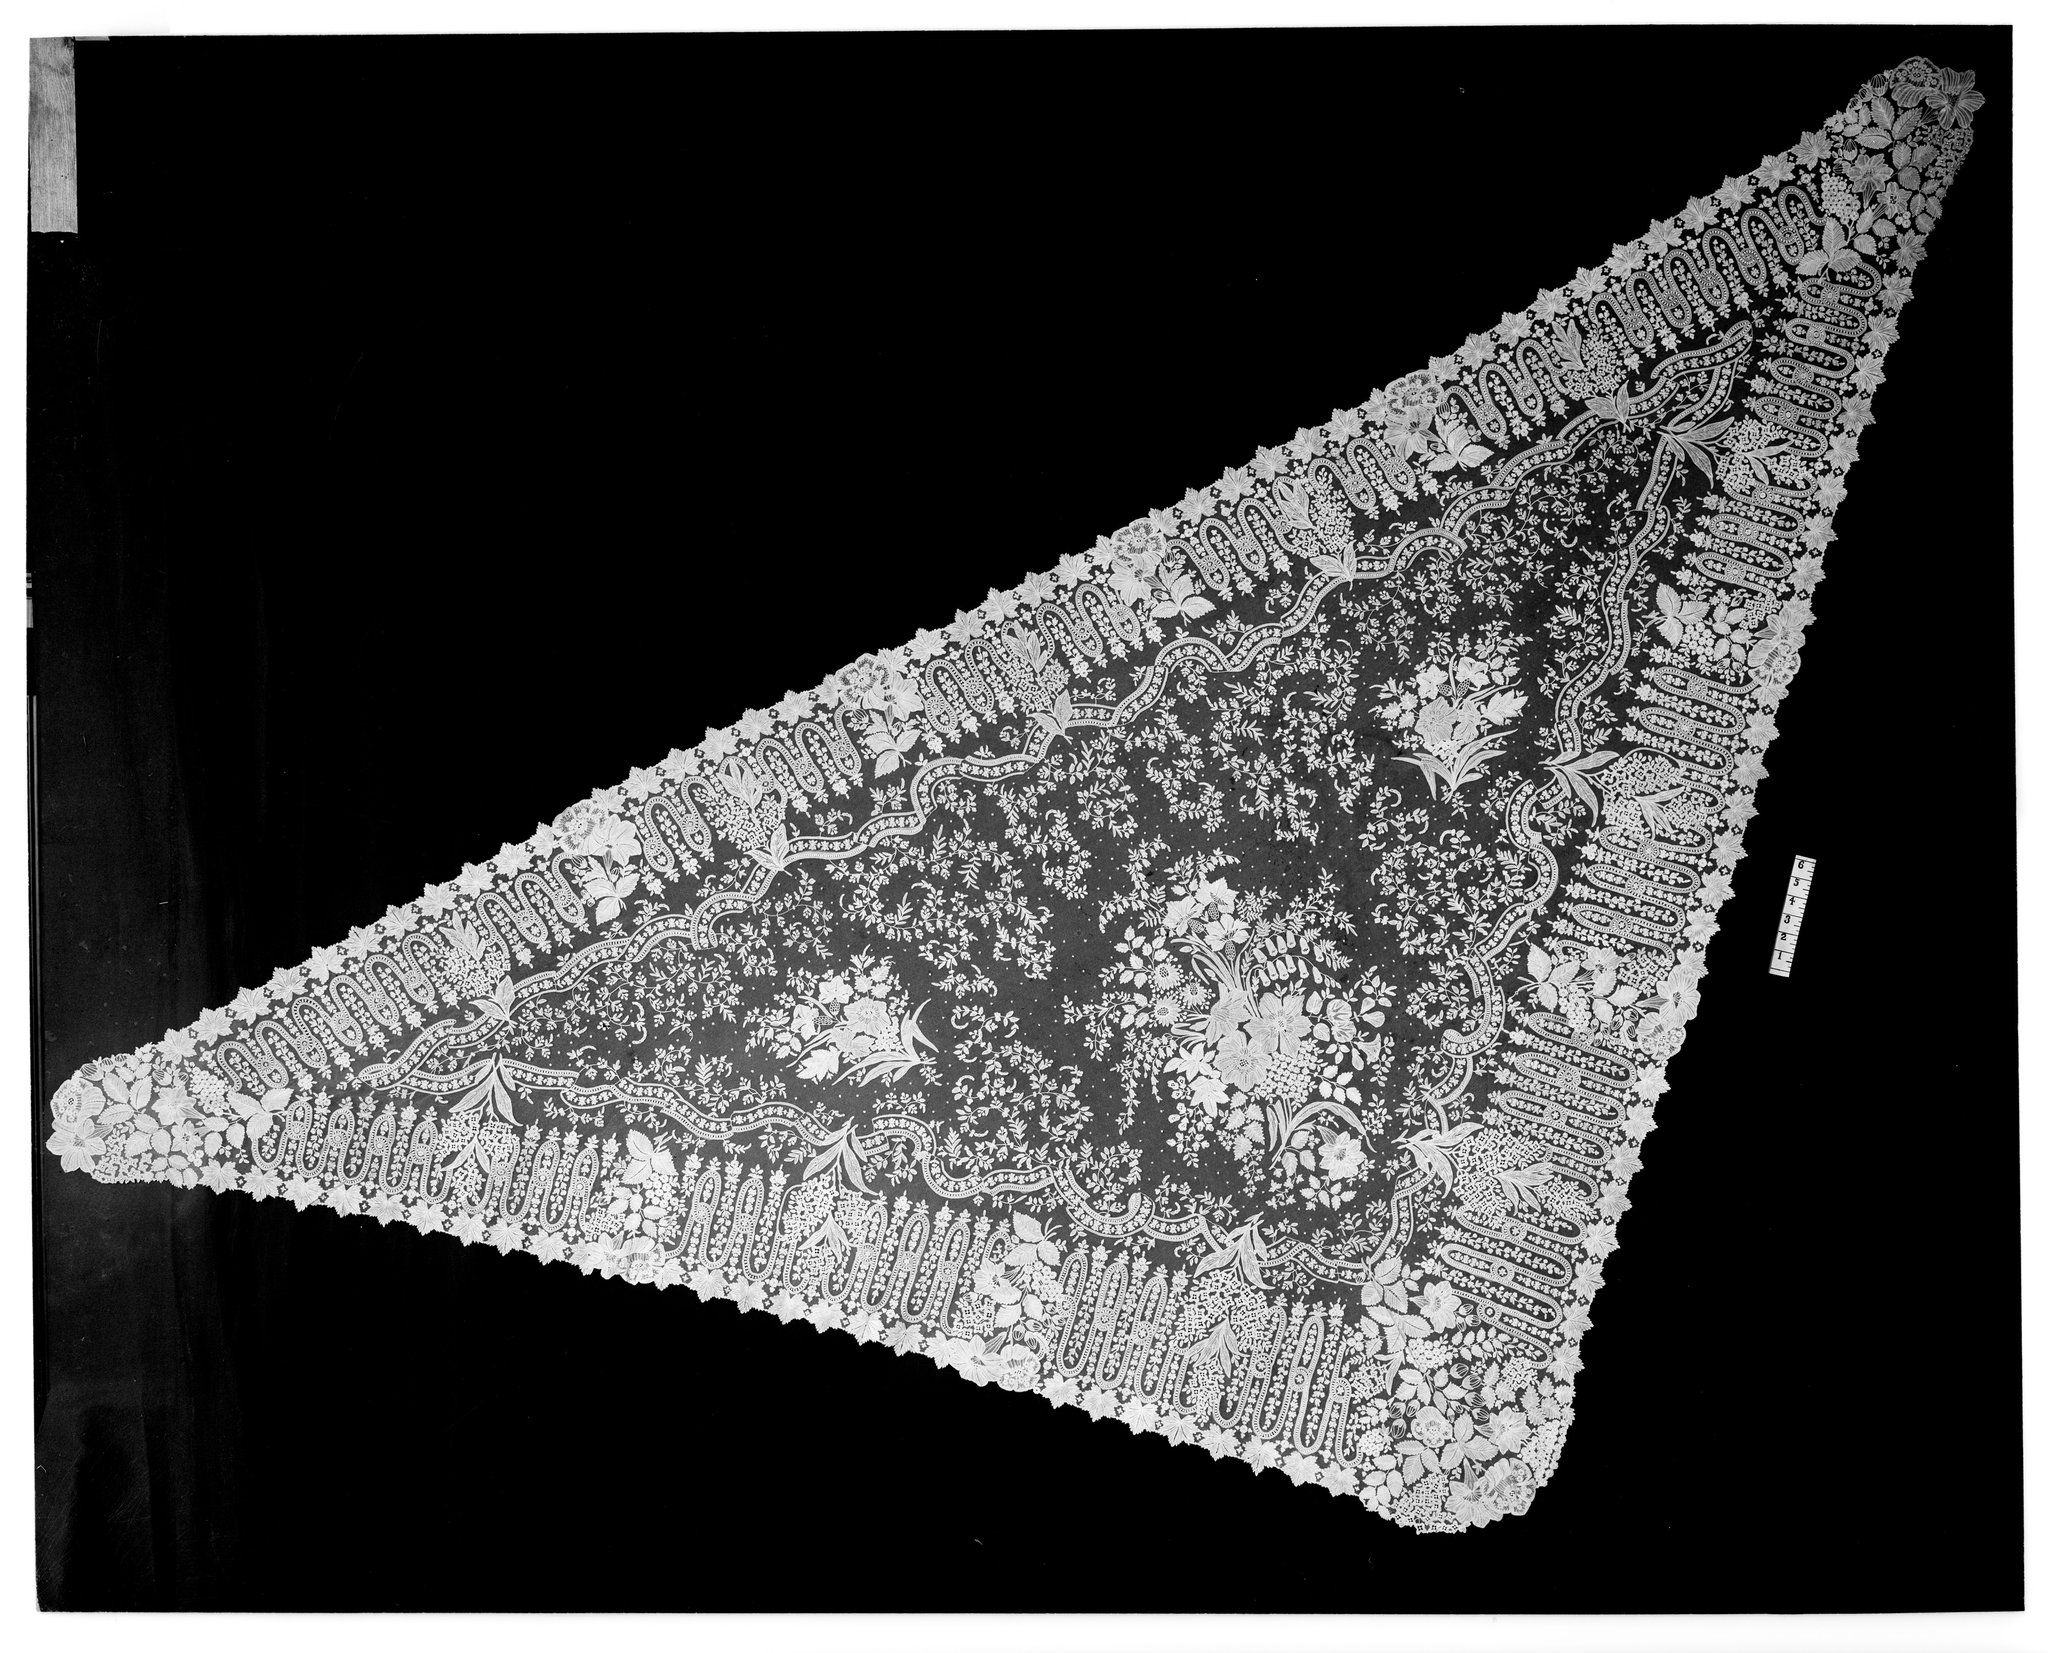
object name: shawl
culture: belgian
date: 1870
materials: cotton, silk